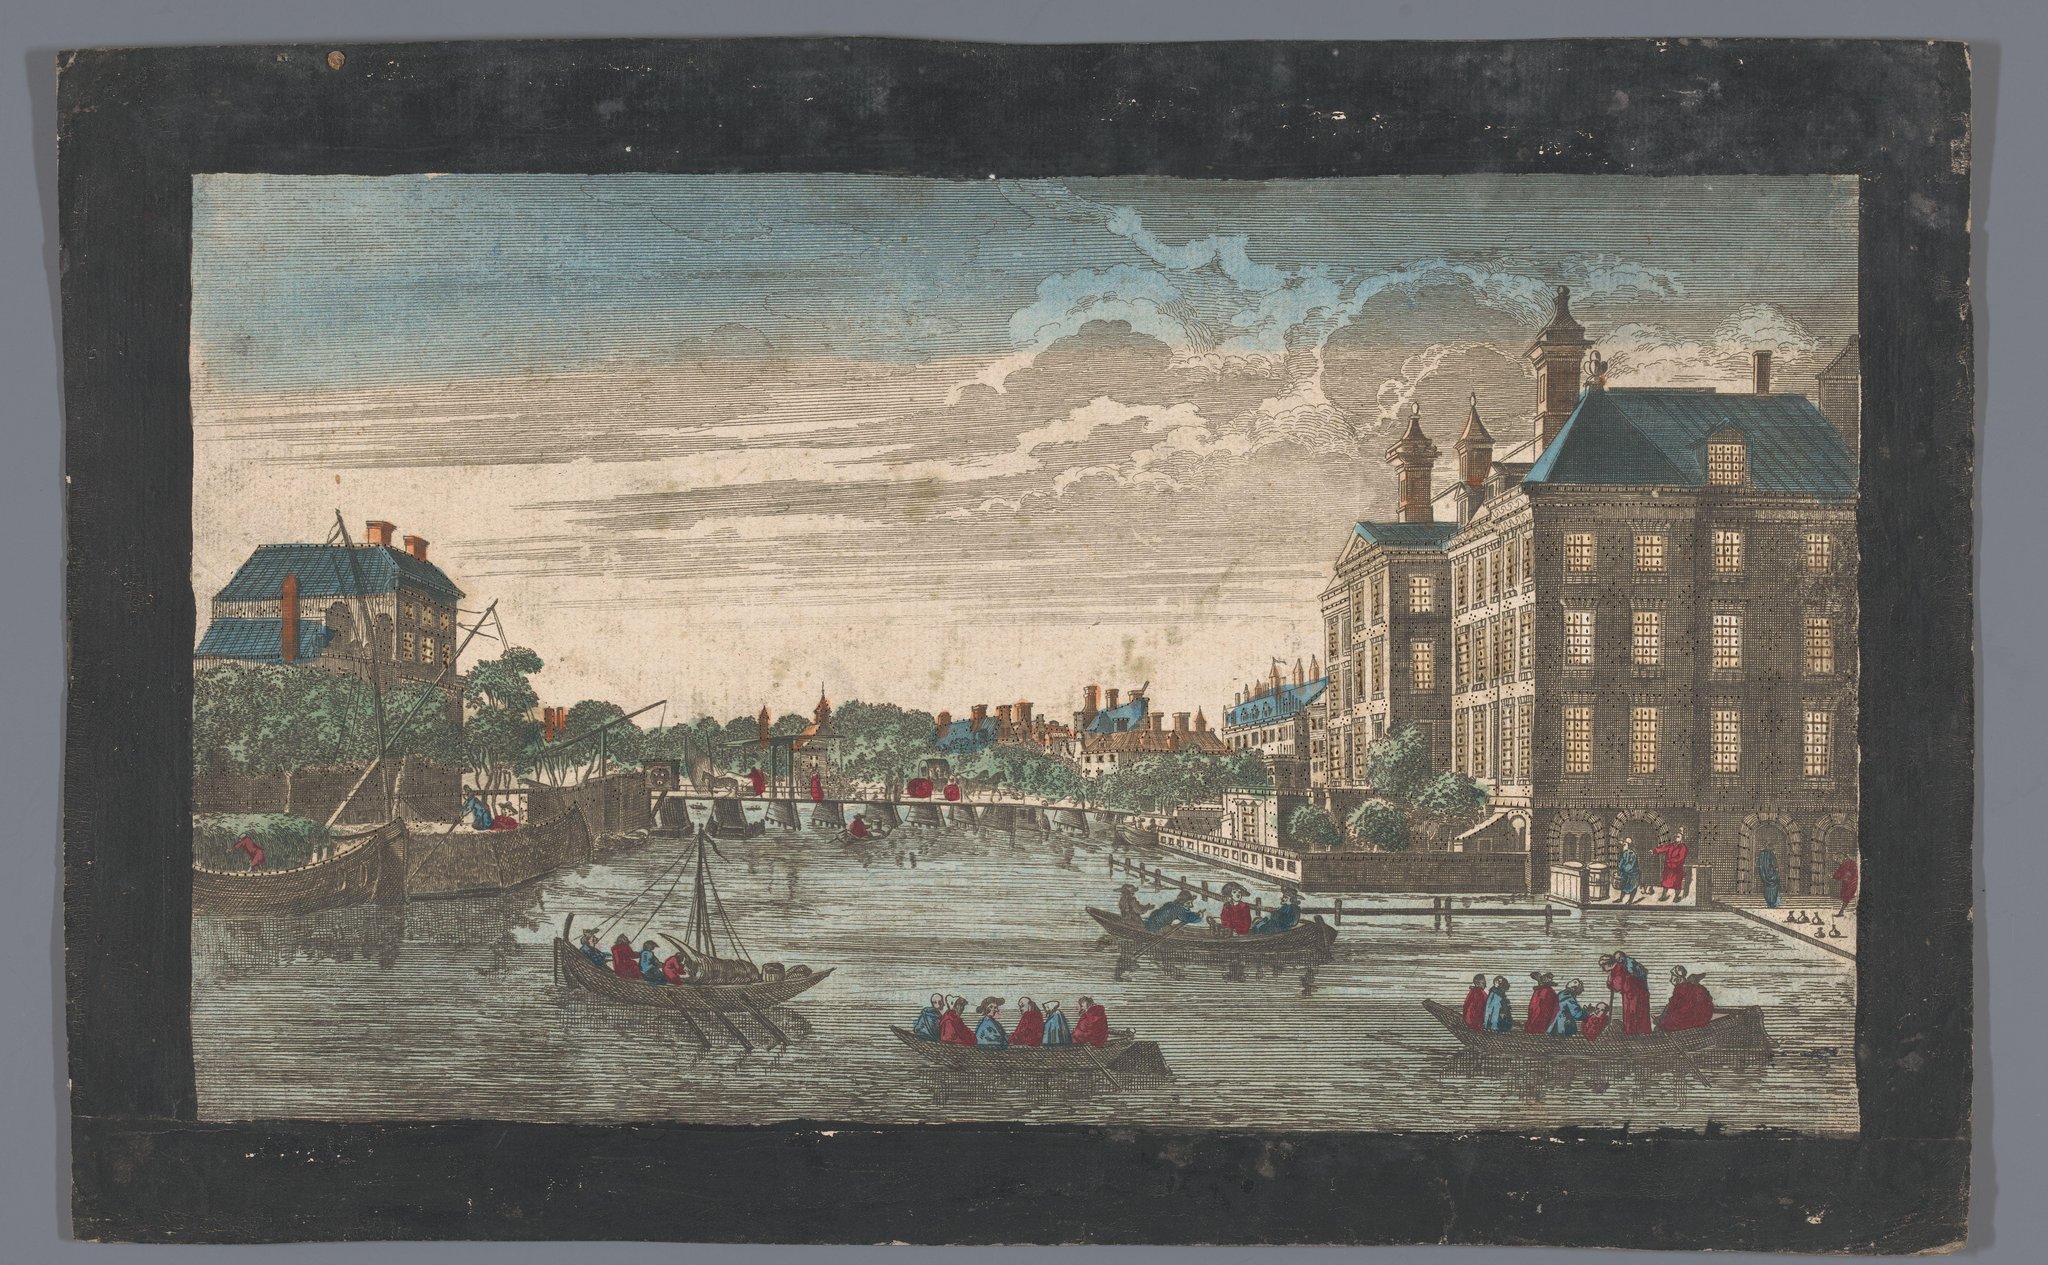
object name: print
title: Gezicht op de Binnen-Amstel en het Diaconieweeshuis te Amsterdam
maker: Anonymous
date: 1700-1799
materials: cardboard, paint, paper, watercolor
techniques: brush, cutting, etching, perforating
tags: bridge in city across river, canal, etc. (+ city(-scape) with figures, staffage), rowing-boat, canoe, etc., orphanage